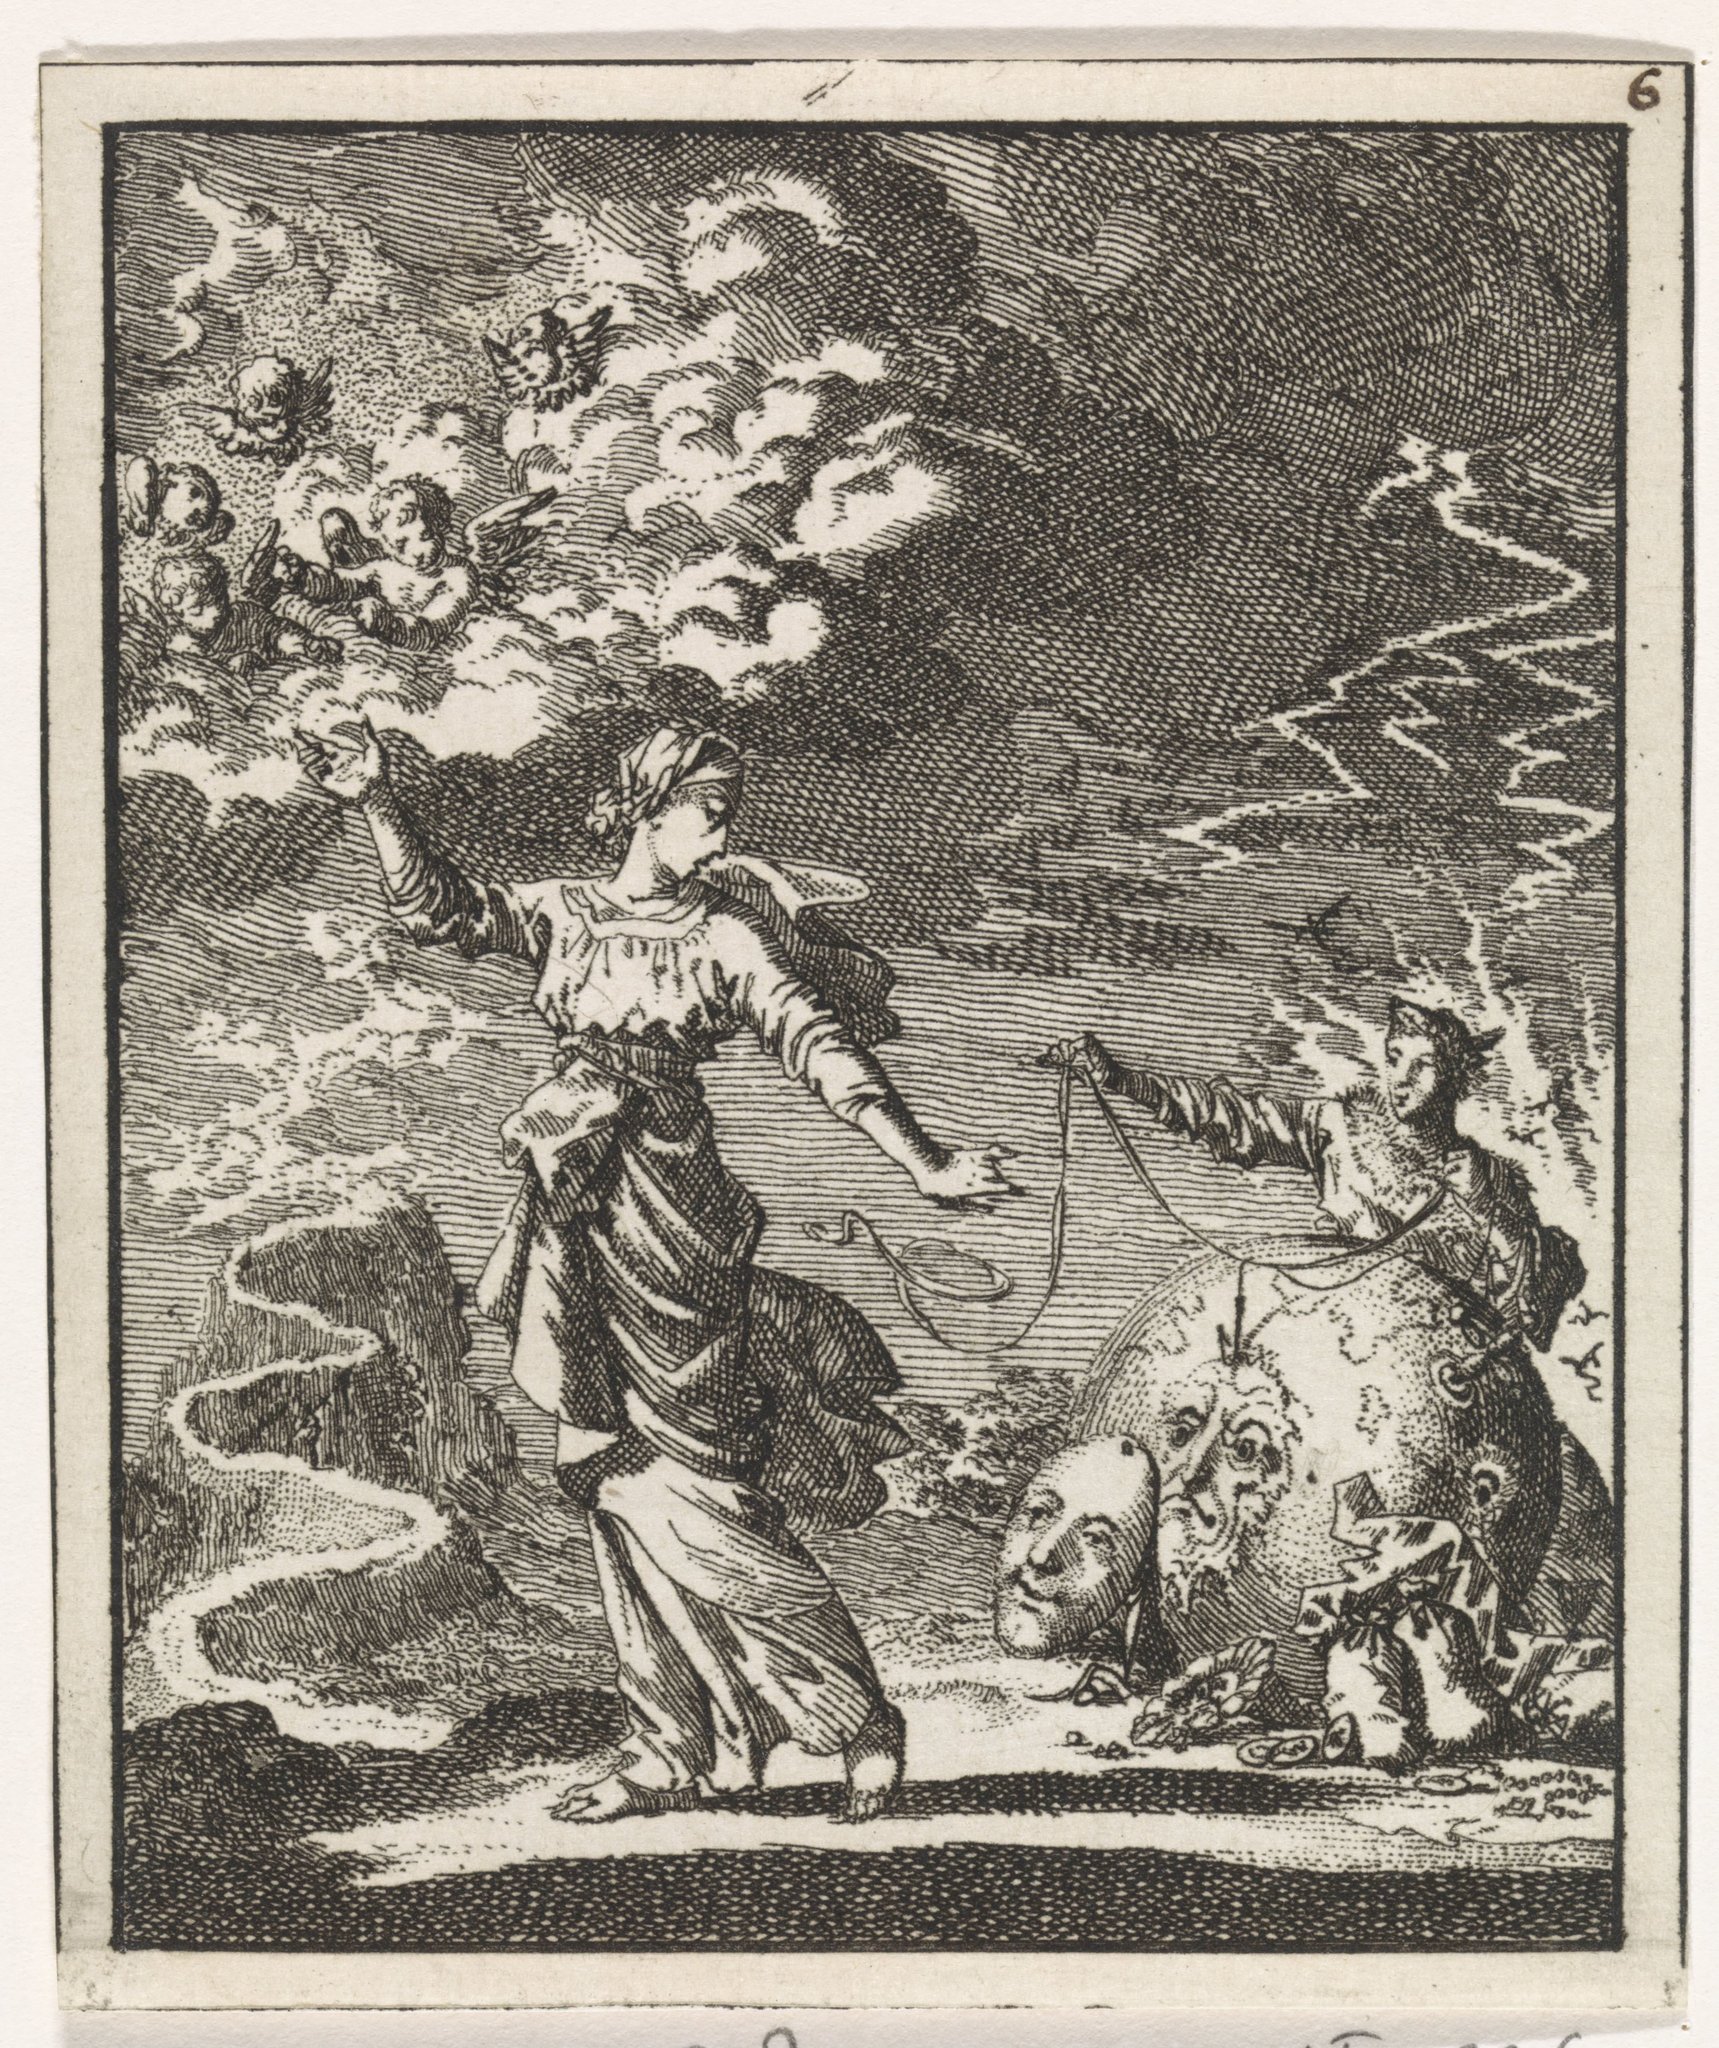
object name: print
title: Vrouw kiest de smalle weg die naar de hemel leidt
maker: jan luyken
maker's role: draughtsman, print maker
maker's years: 1649-1712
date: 1704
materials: paper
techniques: etching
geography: amsterdam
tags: the narrow way ~ doctrine of christ on love, etc.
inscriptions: collector's mark: Lugt 2228, number: ‘6’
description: Proefdruk van illustratie uit: Luyken, Jan. De zedelyke en stichtelyke gezangen. Amsterdam: Wed. Pieter Arentsz (II) en Cornelis van der Sys, 1704, p. 32.